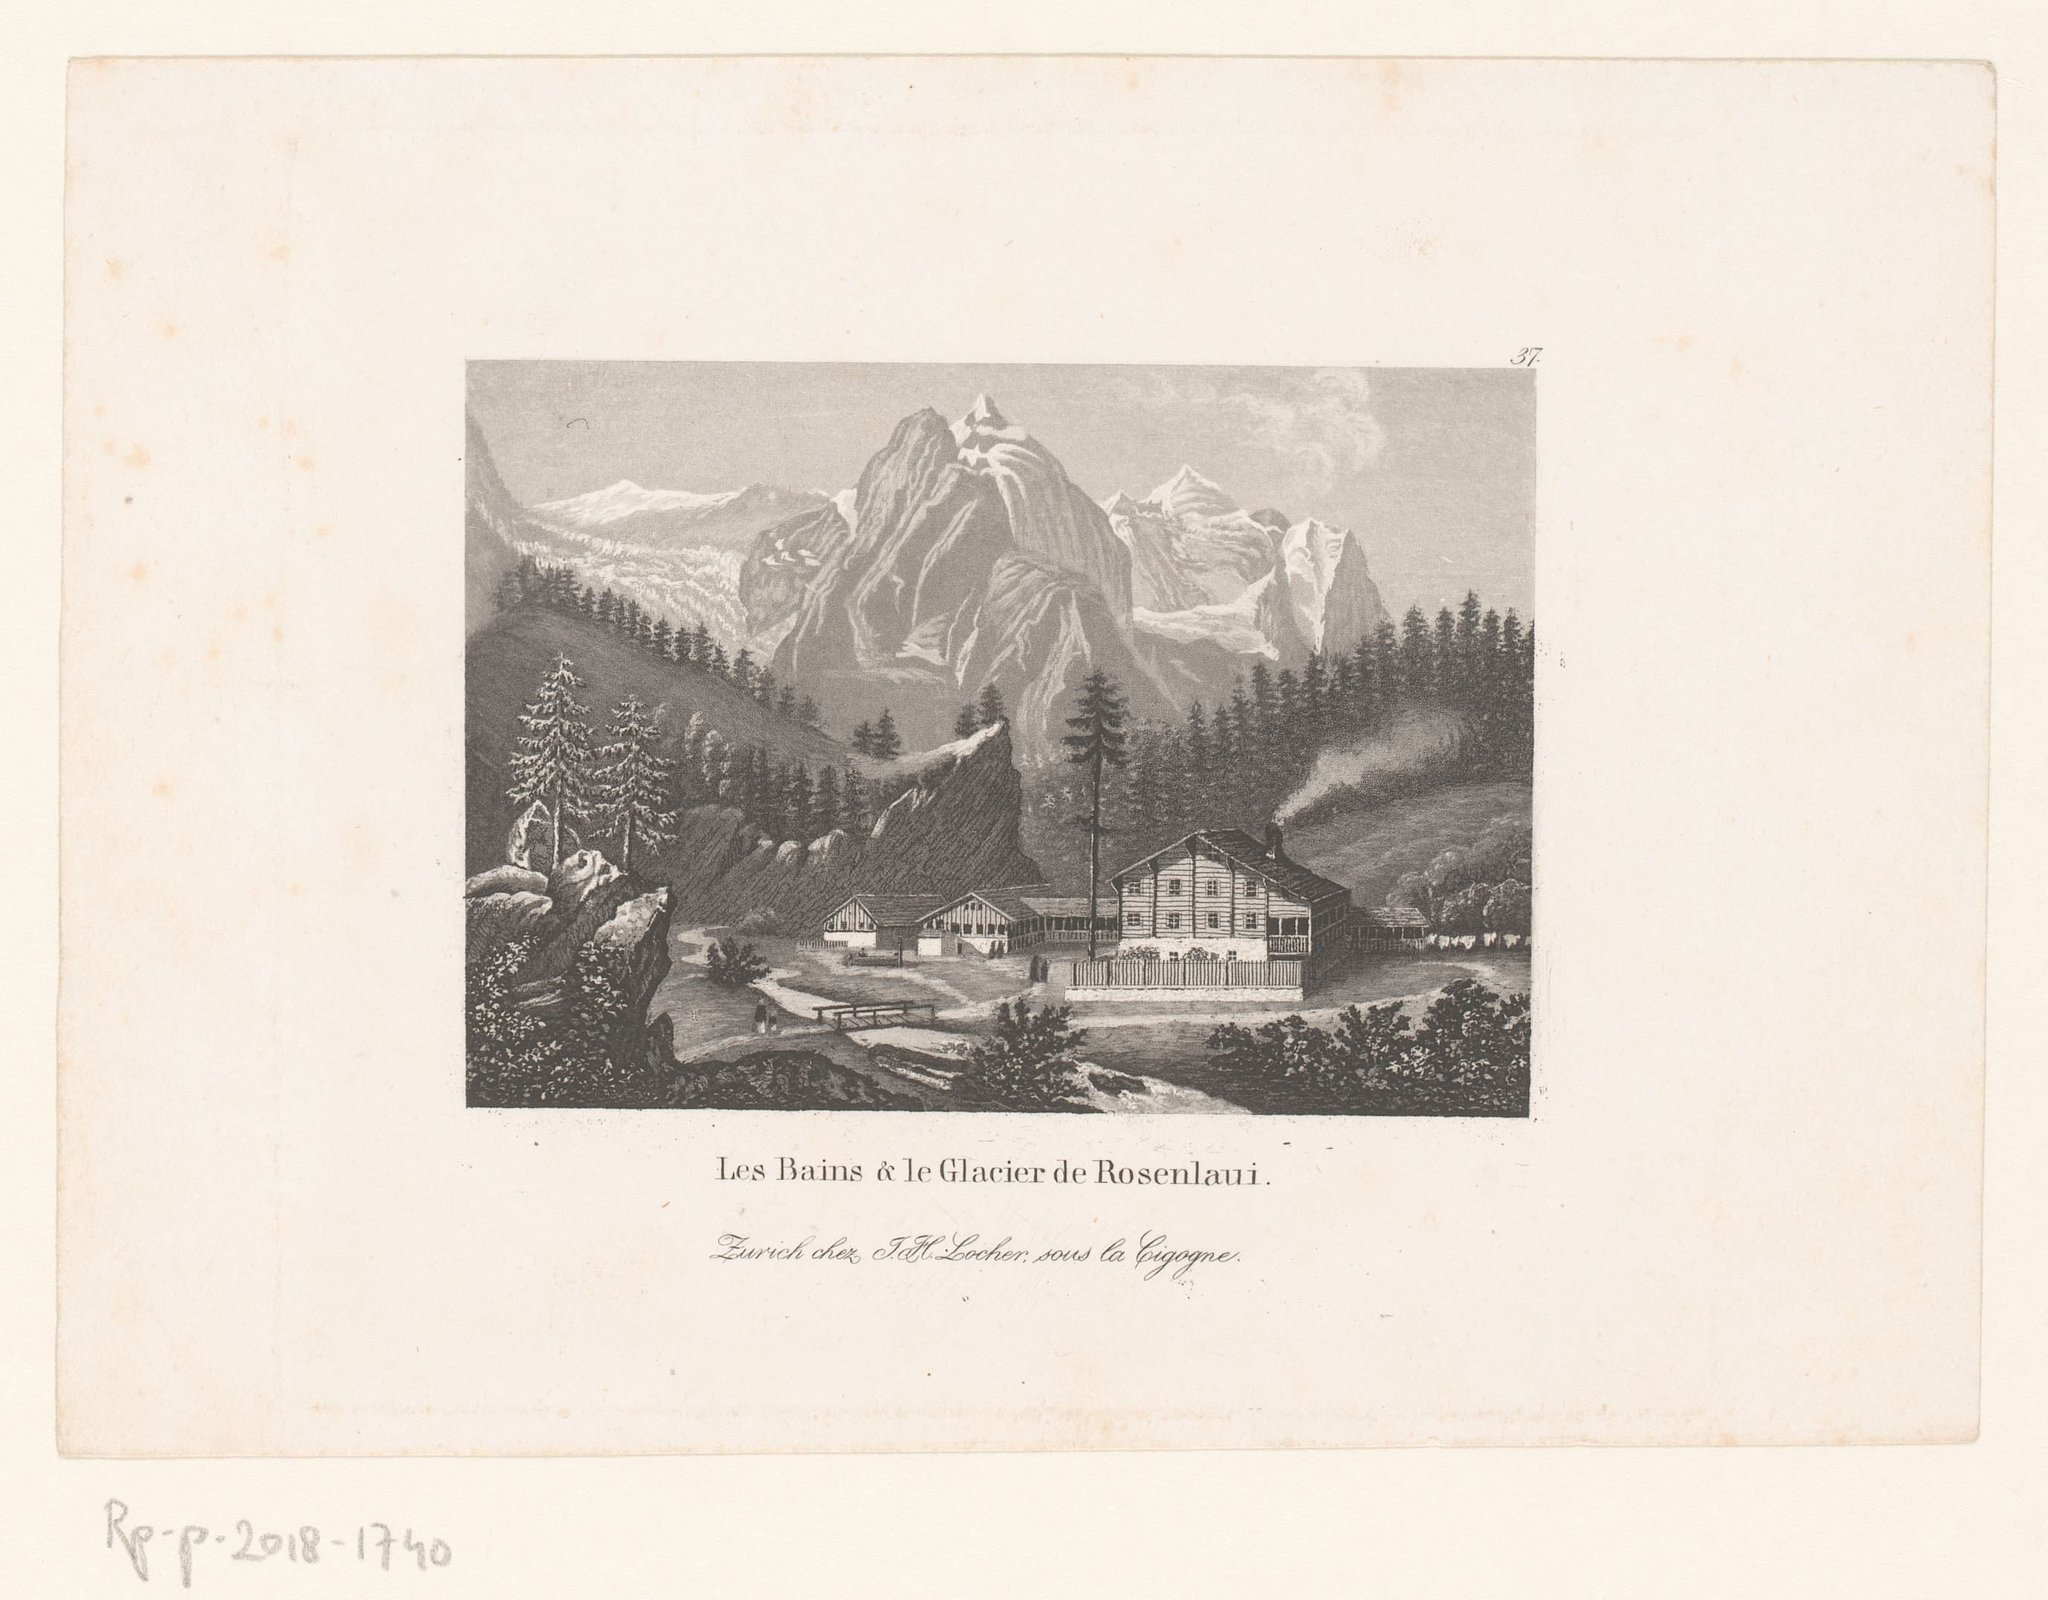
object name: print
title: Gezicht op Rosenlaui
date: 1820-1892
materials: paper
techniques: aquatint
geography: zurich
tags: prospect of village, silhouette of village, glacier, spring (fluids extracted from the earth)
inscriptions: collector's mark: Lugt 2228